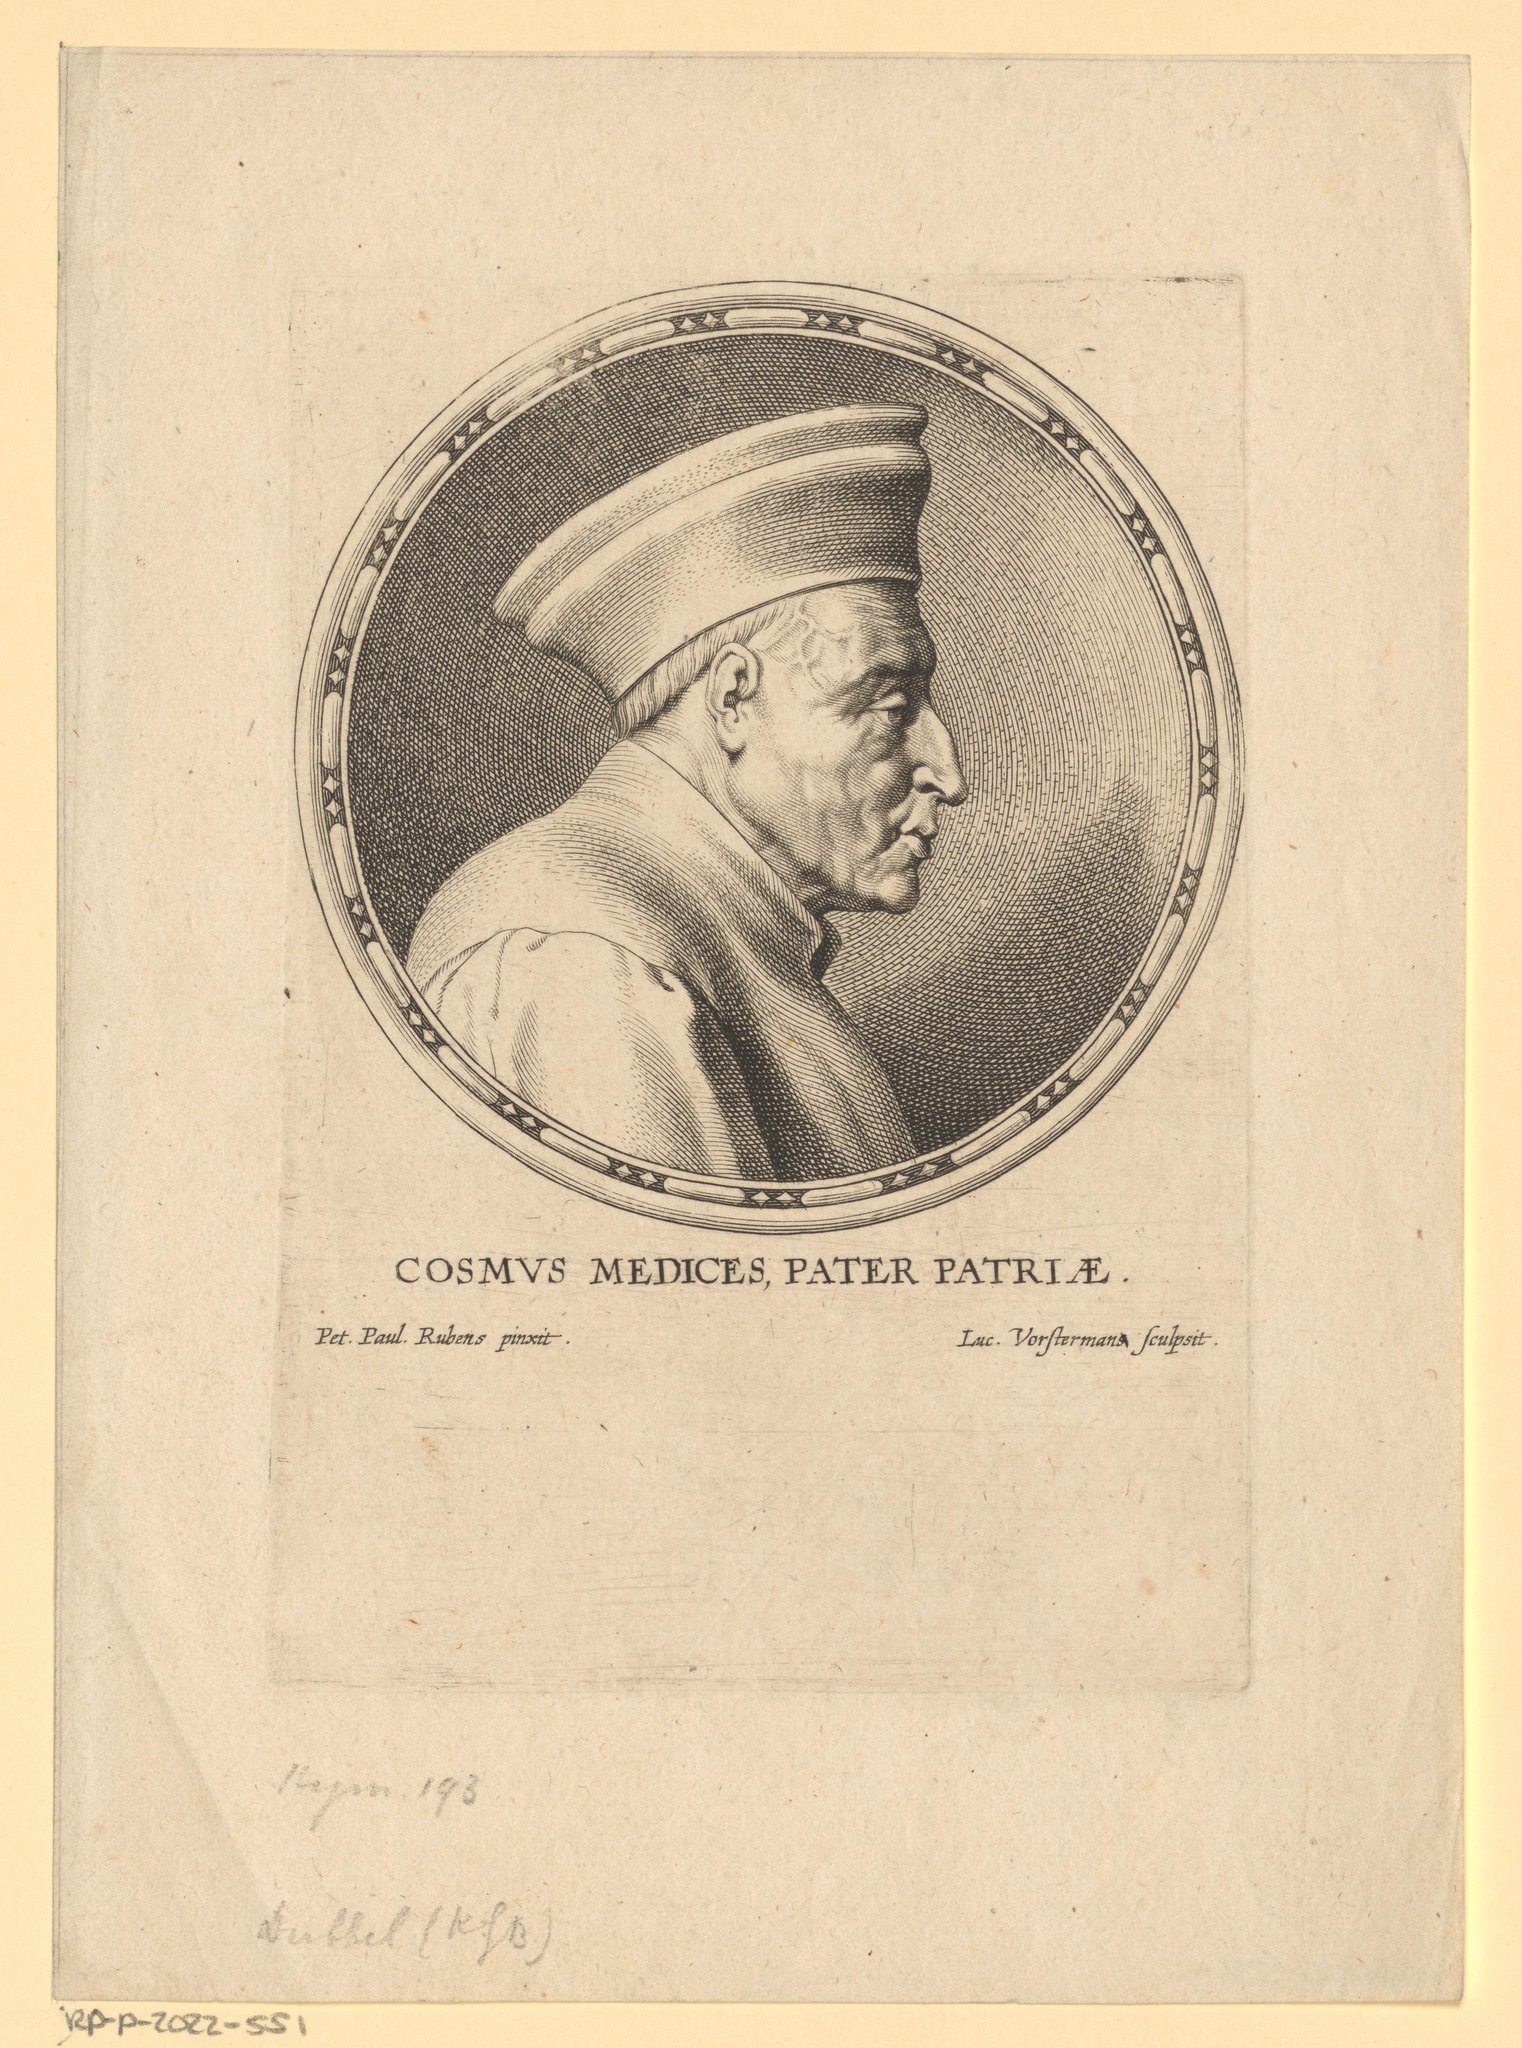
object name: print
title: Portret van Cosimo de' Medici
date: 1619-1675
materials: paper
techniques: engraving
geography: antwerp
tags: politician, historical persons